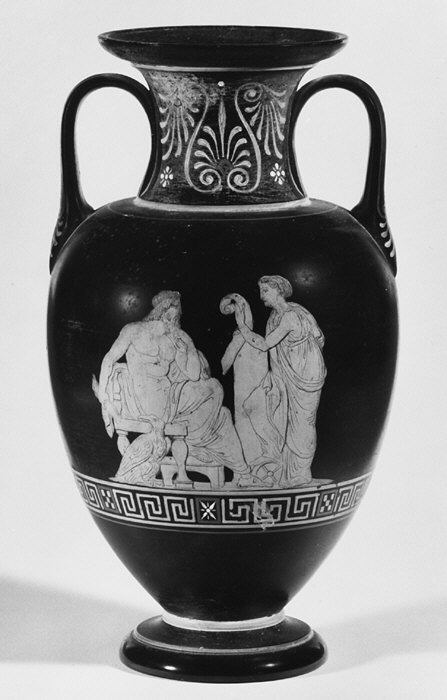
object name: vase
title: Pair of vases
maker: frederick sonne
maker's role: manufacturer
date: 1875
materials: terracotta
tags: eagles,jupiter,goddess